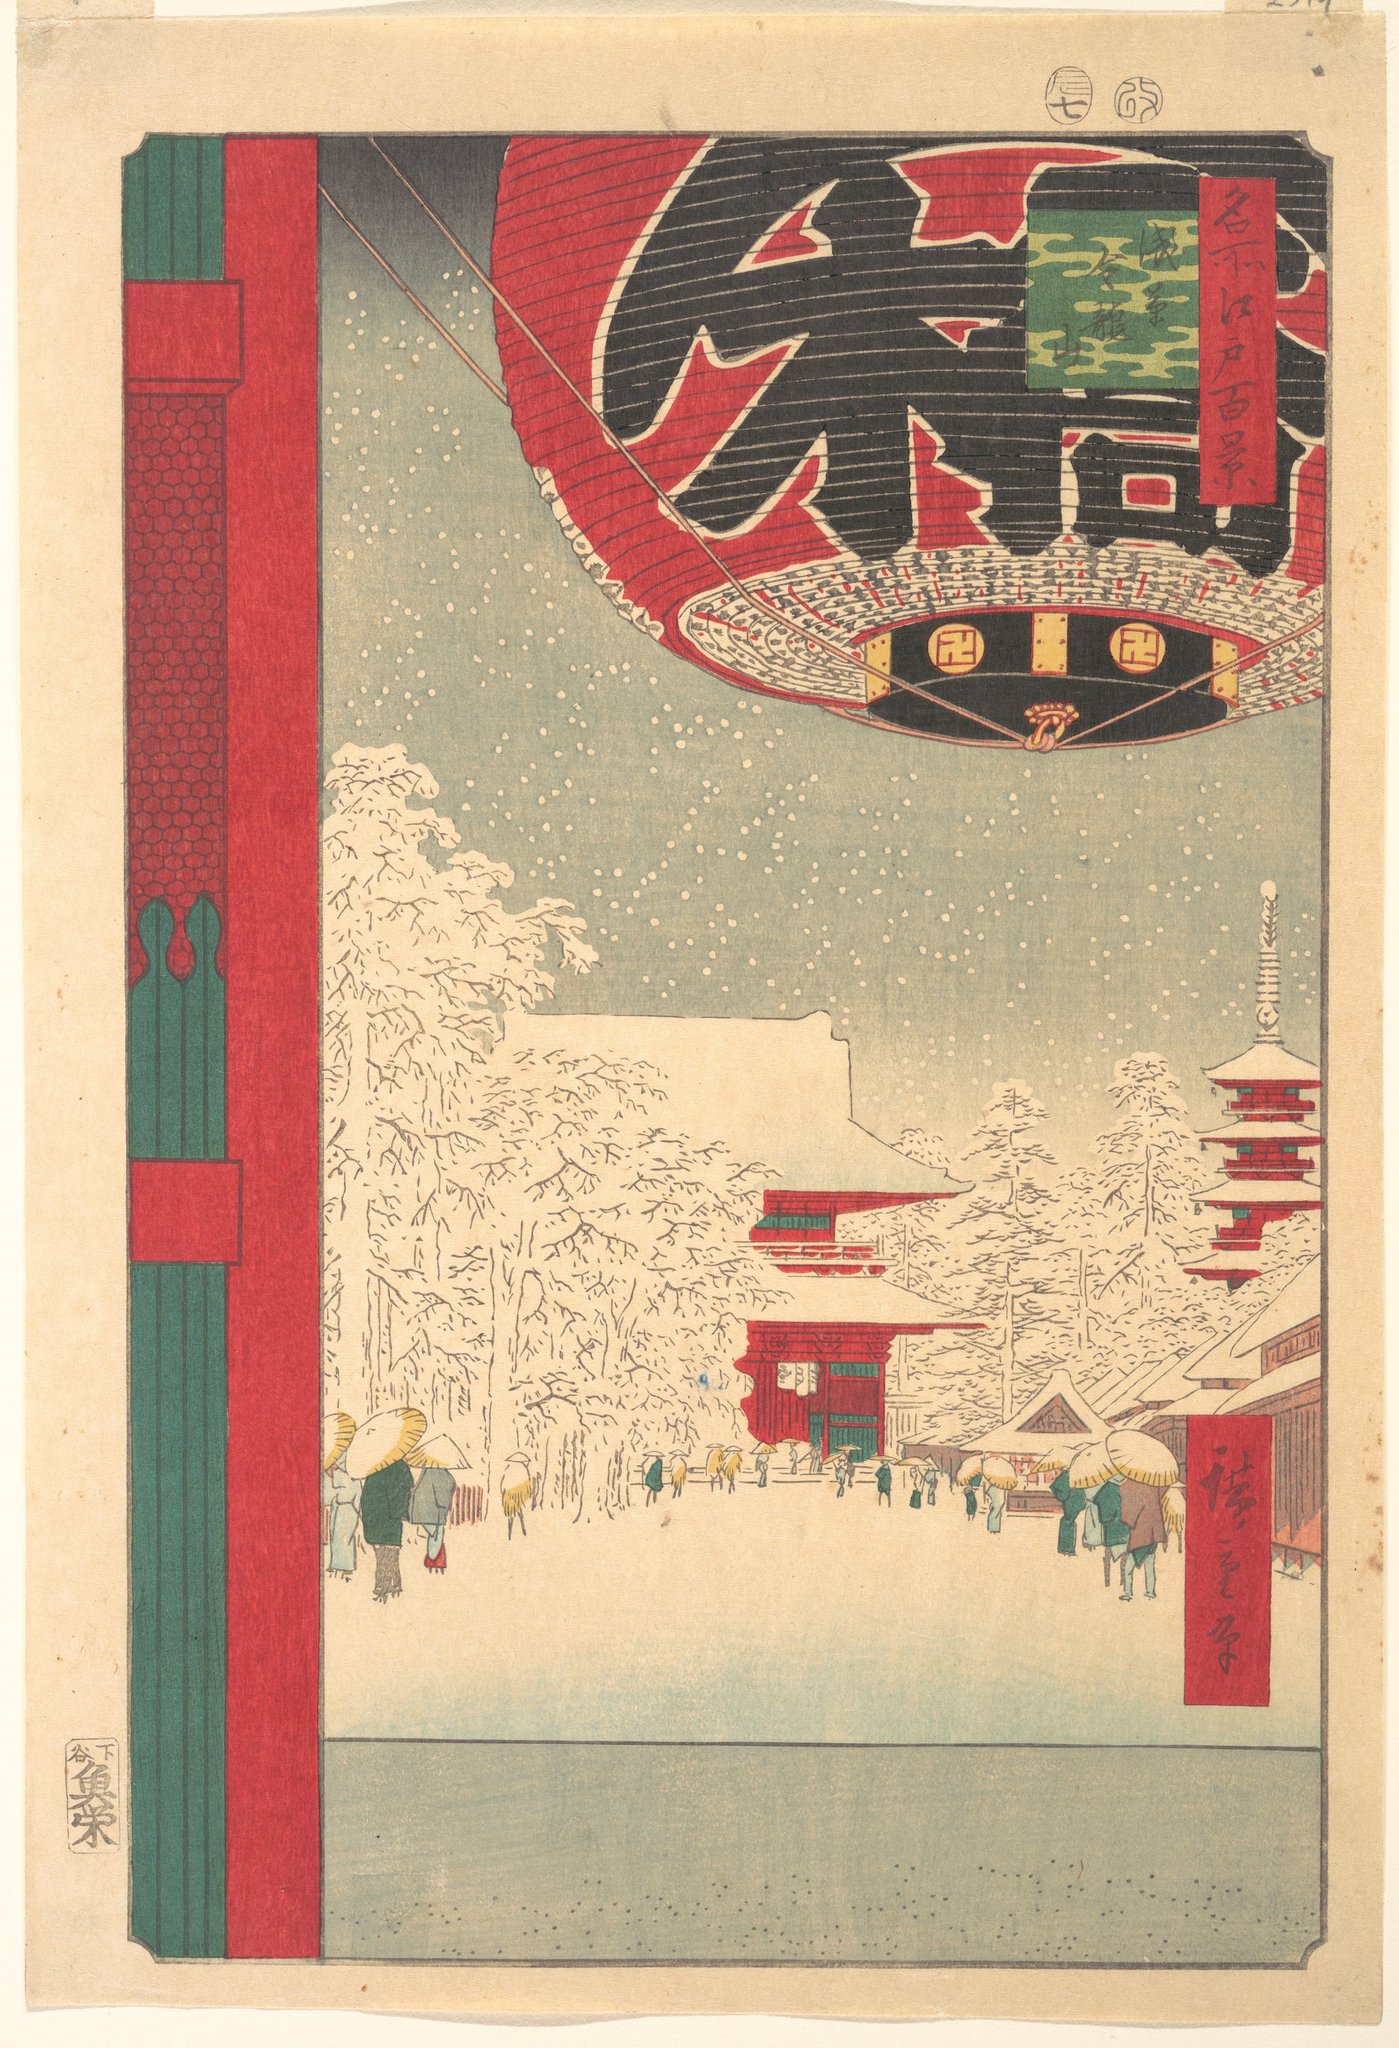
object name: print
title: Kinryūsan Temple at Asakusa, from the series "One Hundred Famous Views of Edo"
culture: japanese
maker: utagawa hiroshige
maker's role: artist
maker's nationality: japanese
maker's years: 1797-1858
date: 1856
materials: ink, paper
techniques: woodblock print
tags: temples,snow,lanterns